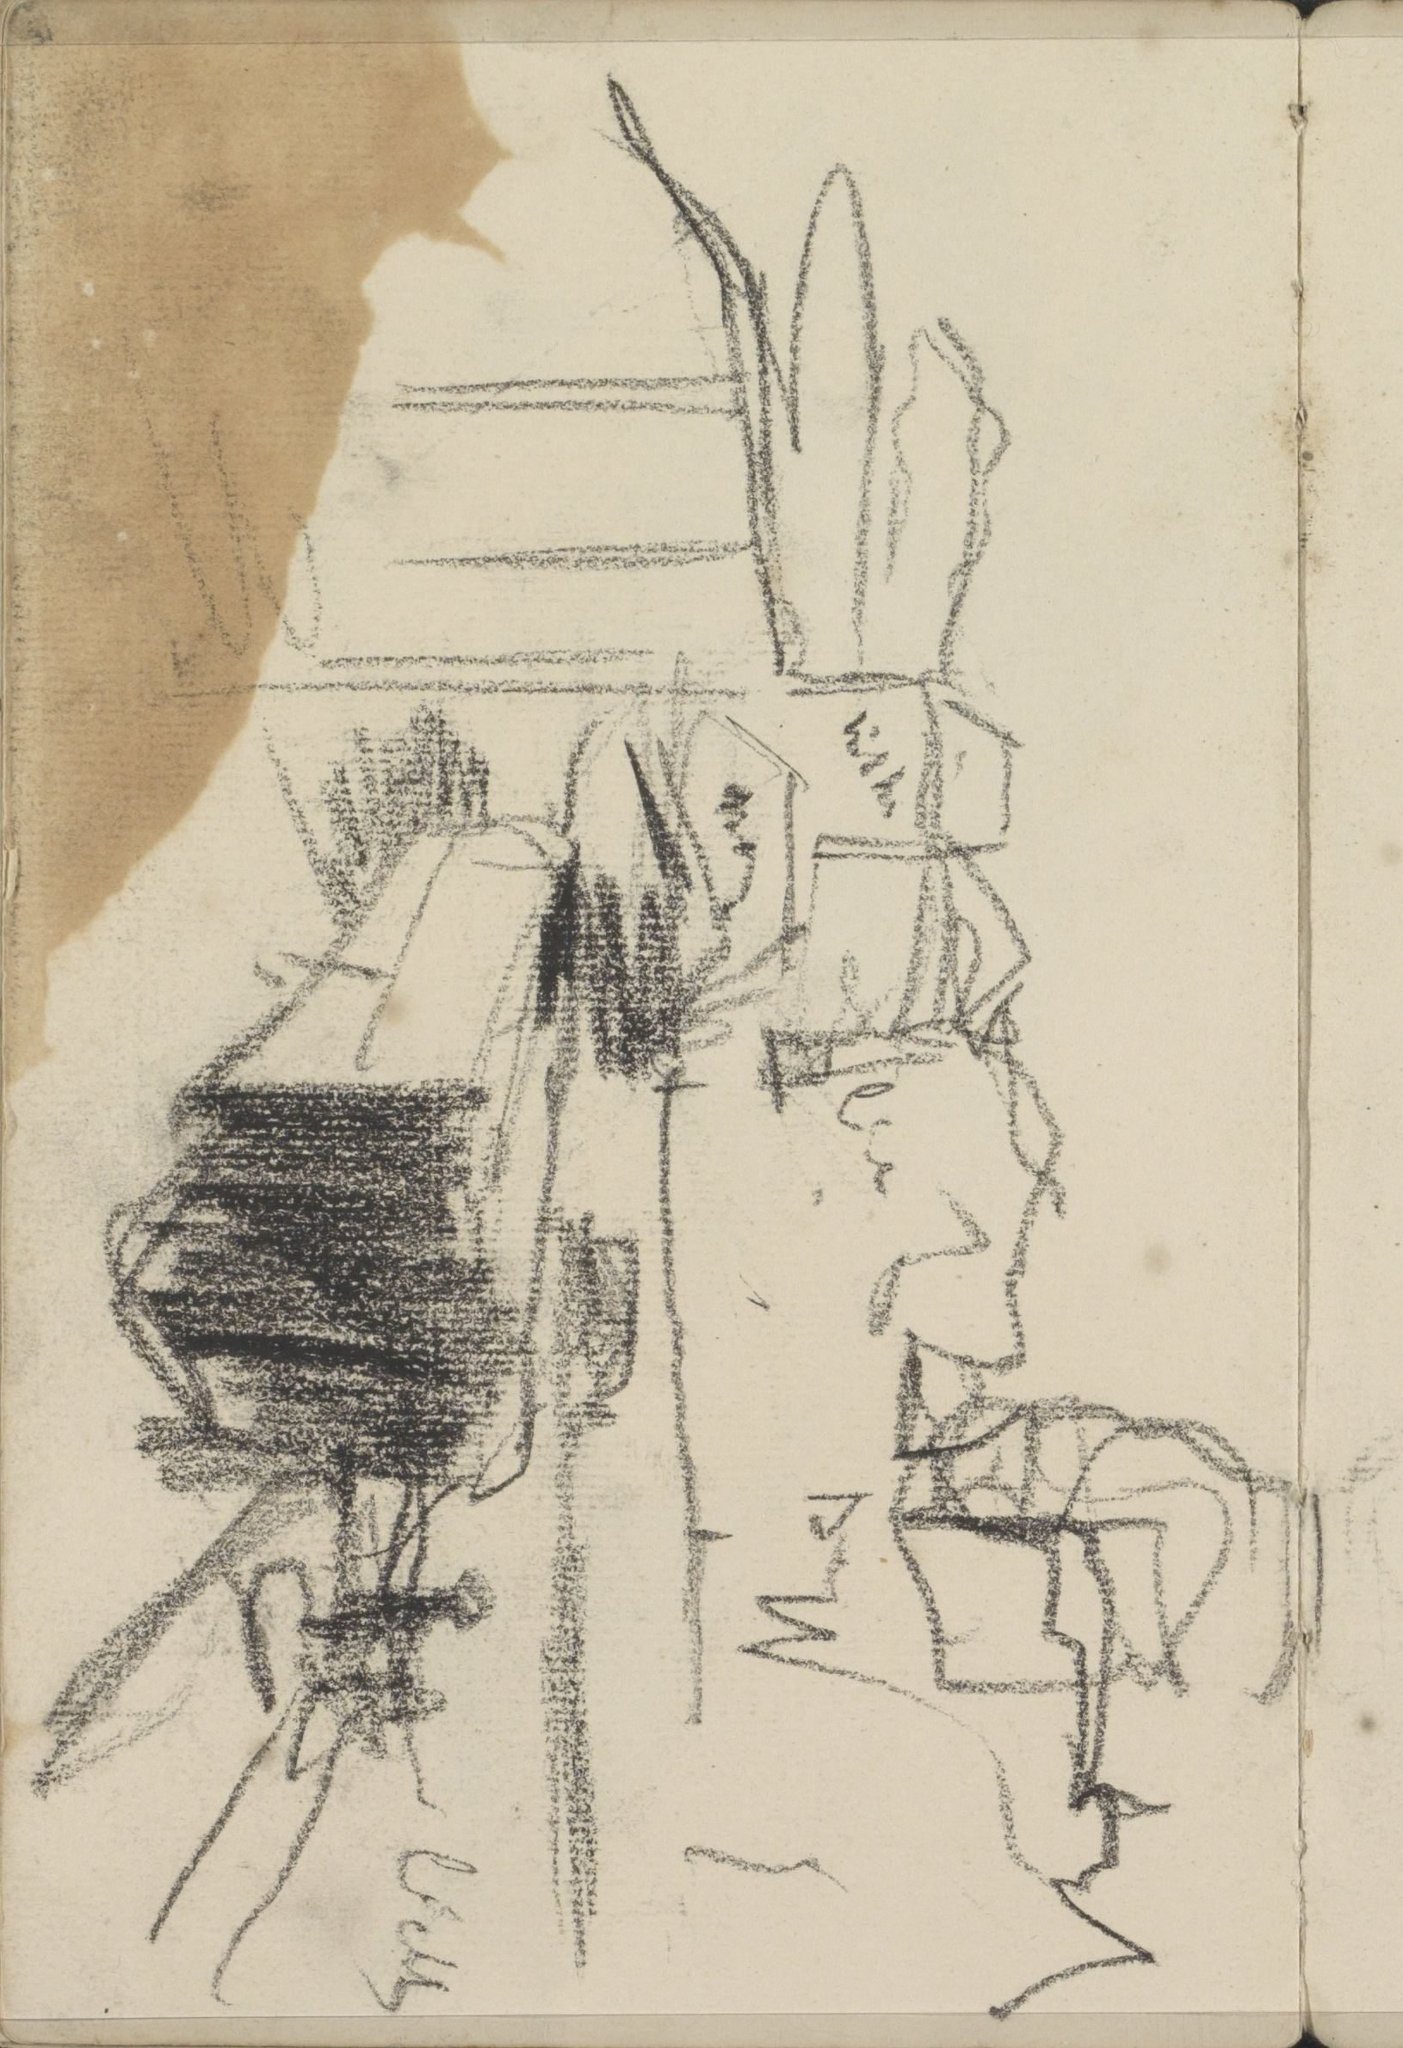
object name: sketchbook leaf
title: Gezicht op een gracht, mogelijk het Rokin te Amsterdam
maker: george hendrik breitner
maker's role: draughtsman, painter, print maker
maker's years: 1857-1923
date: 1886-1923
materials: chalk, paper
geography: amsterdam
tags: ships (in general), canals, waters (in city), civic architecture; edifices; dwellings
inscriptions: kleurnotitie, handgeschreven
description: Pagina 31 uit een schetsboek met 17 bladen.